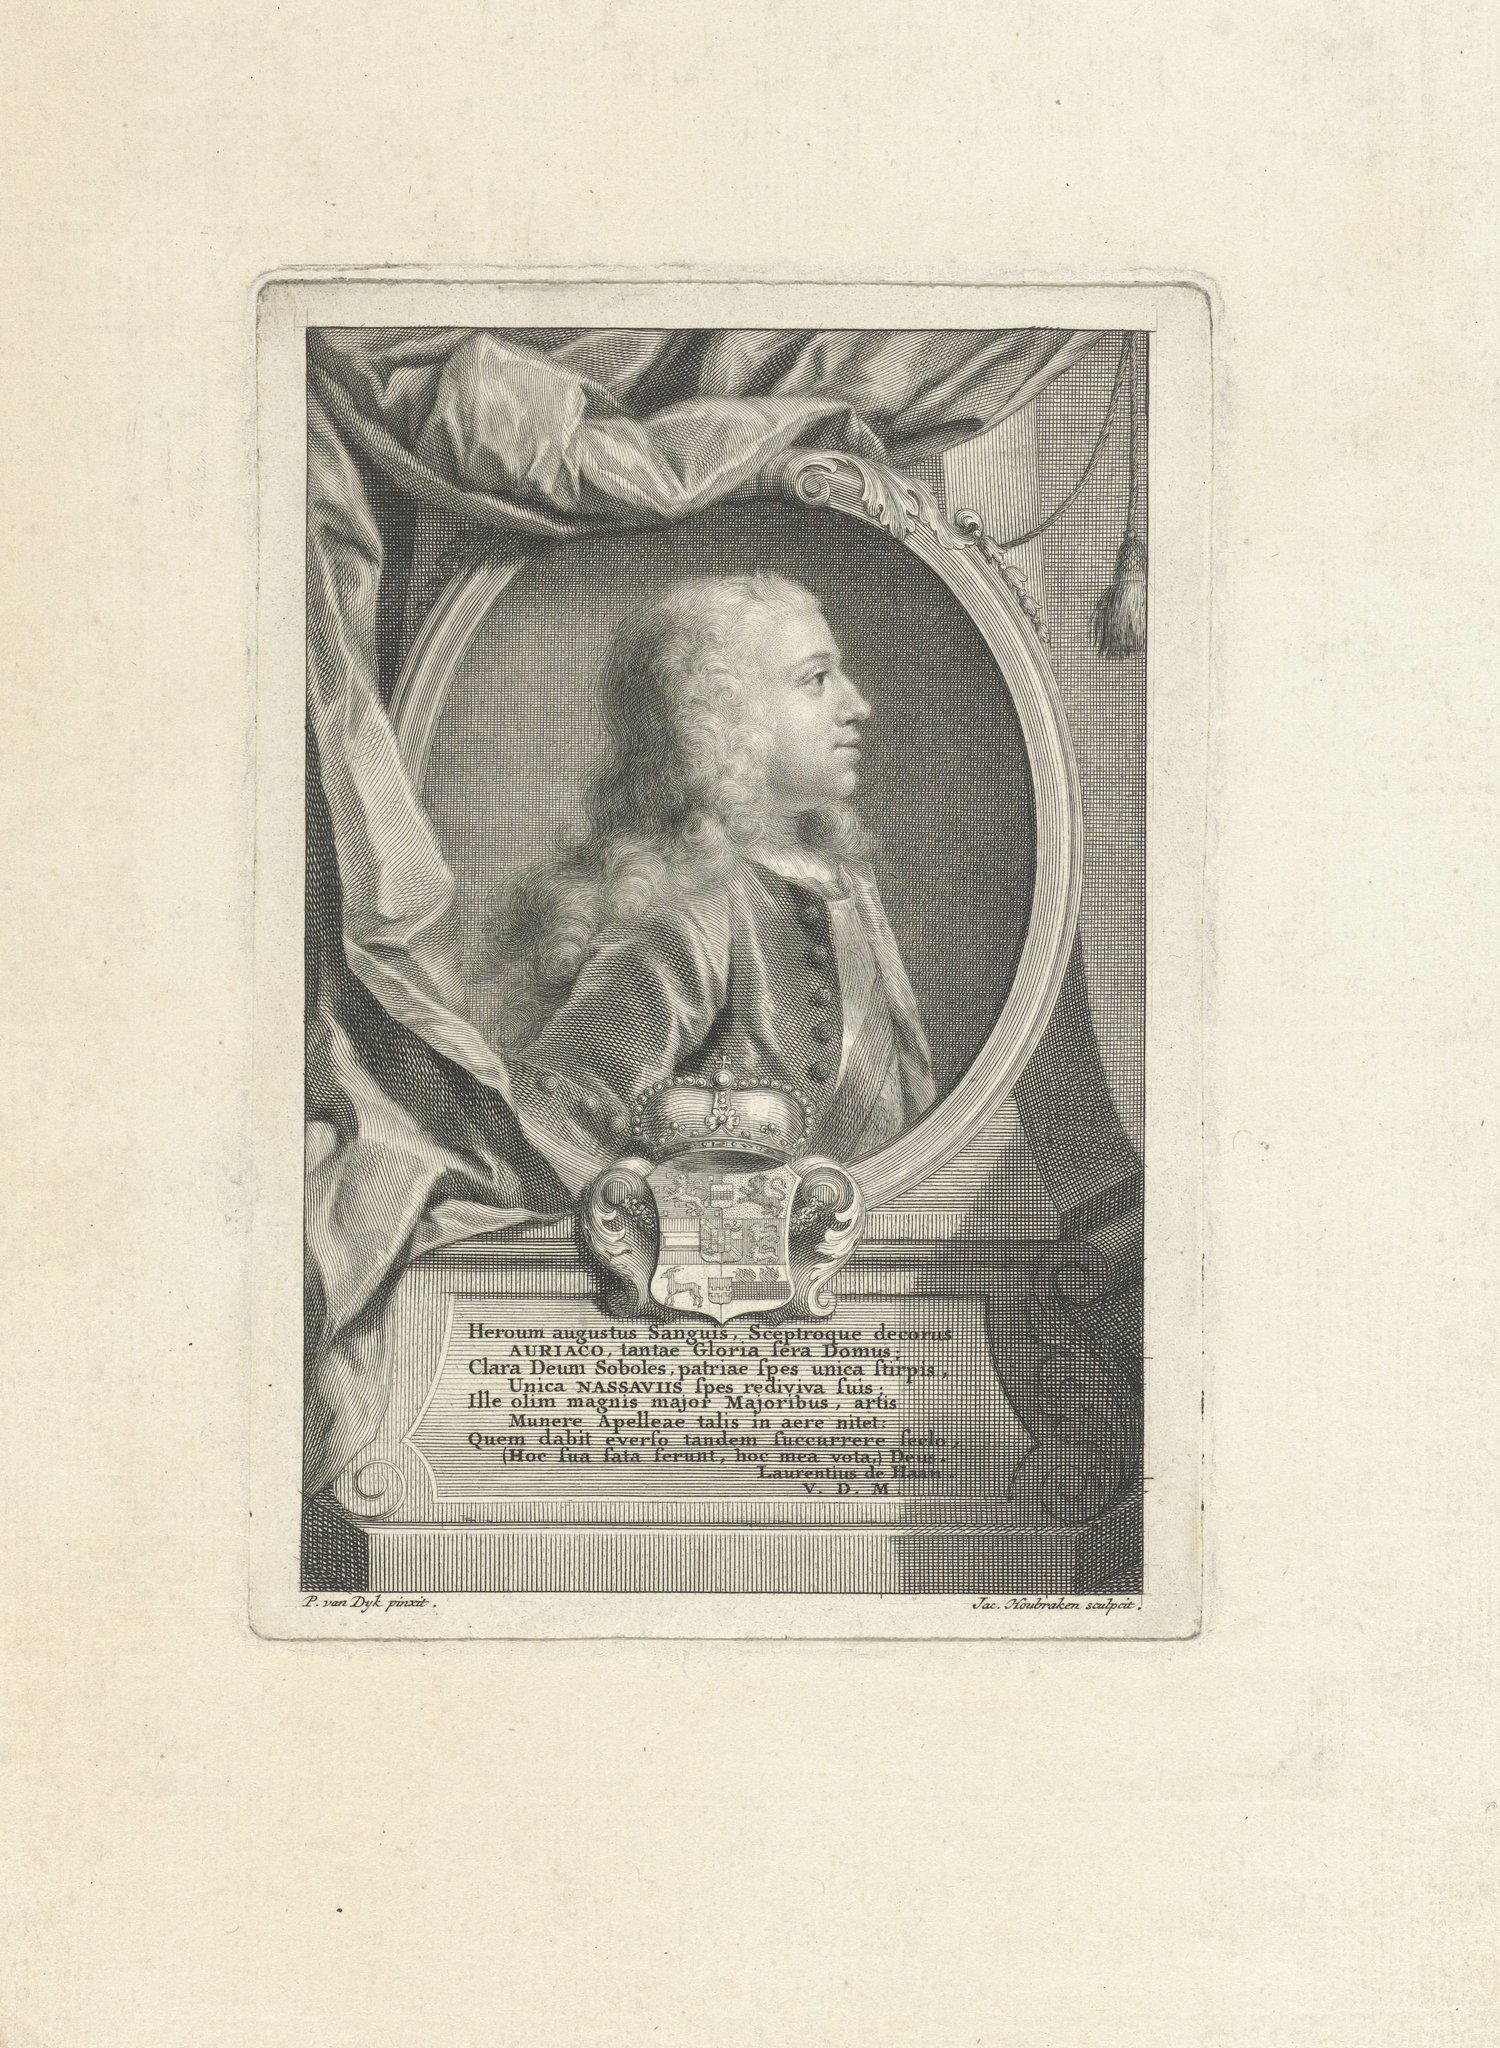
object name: print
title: Portret van Willem IV, prins van Oranje-Nassau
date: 1721-1731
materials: paper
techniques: engraving, etching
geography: amsterdam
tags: the hague, willem iv (prins van oranje-nassau)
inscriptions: collector's mark: Lugt 240